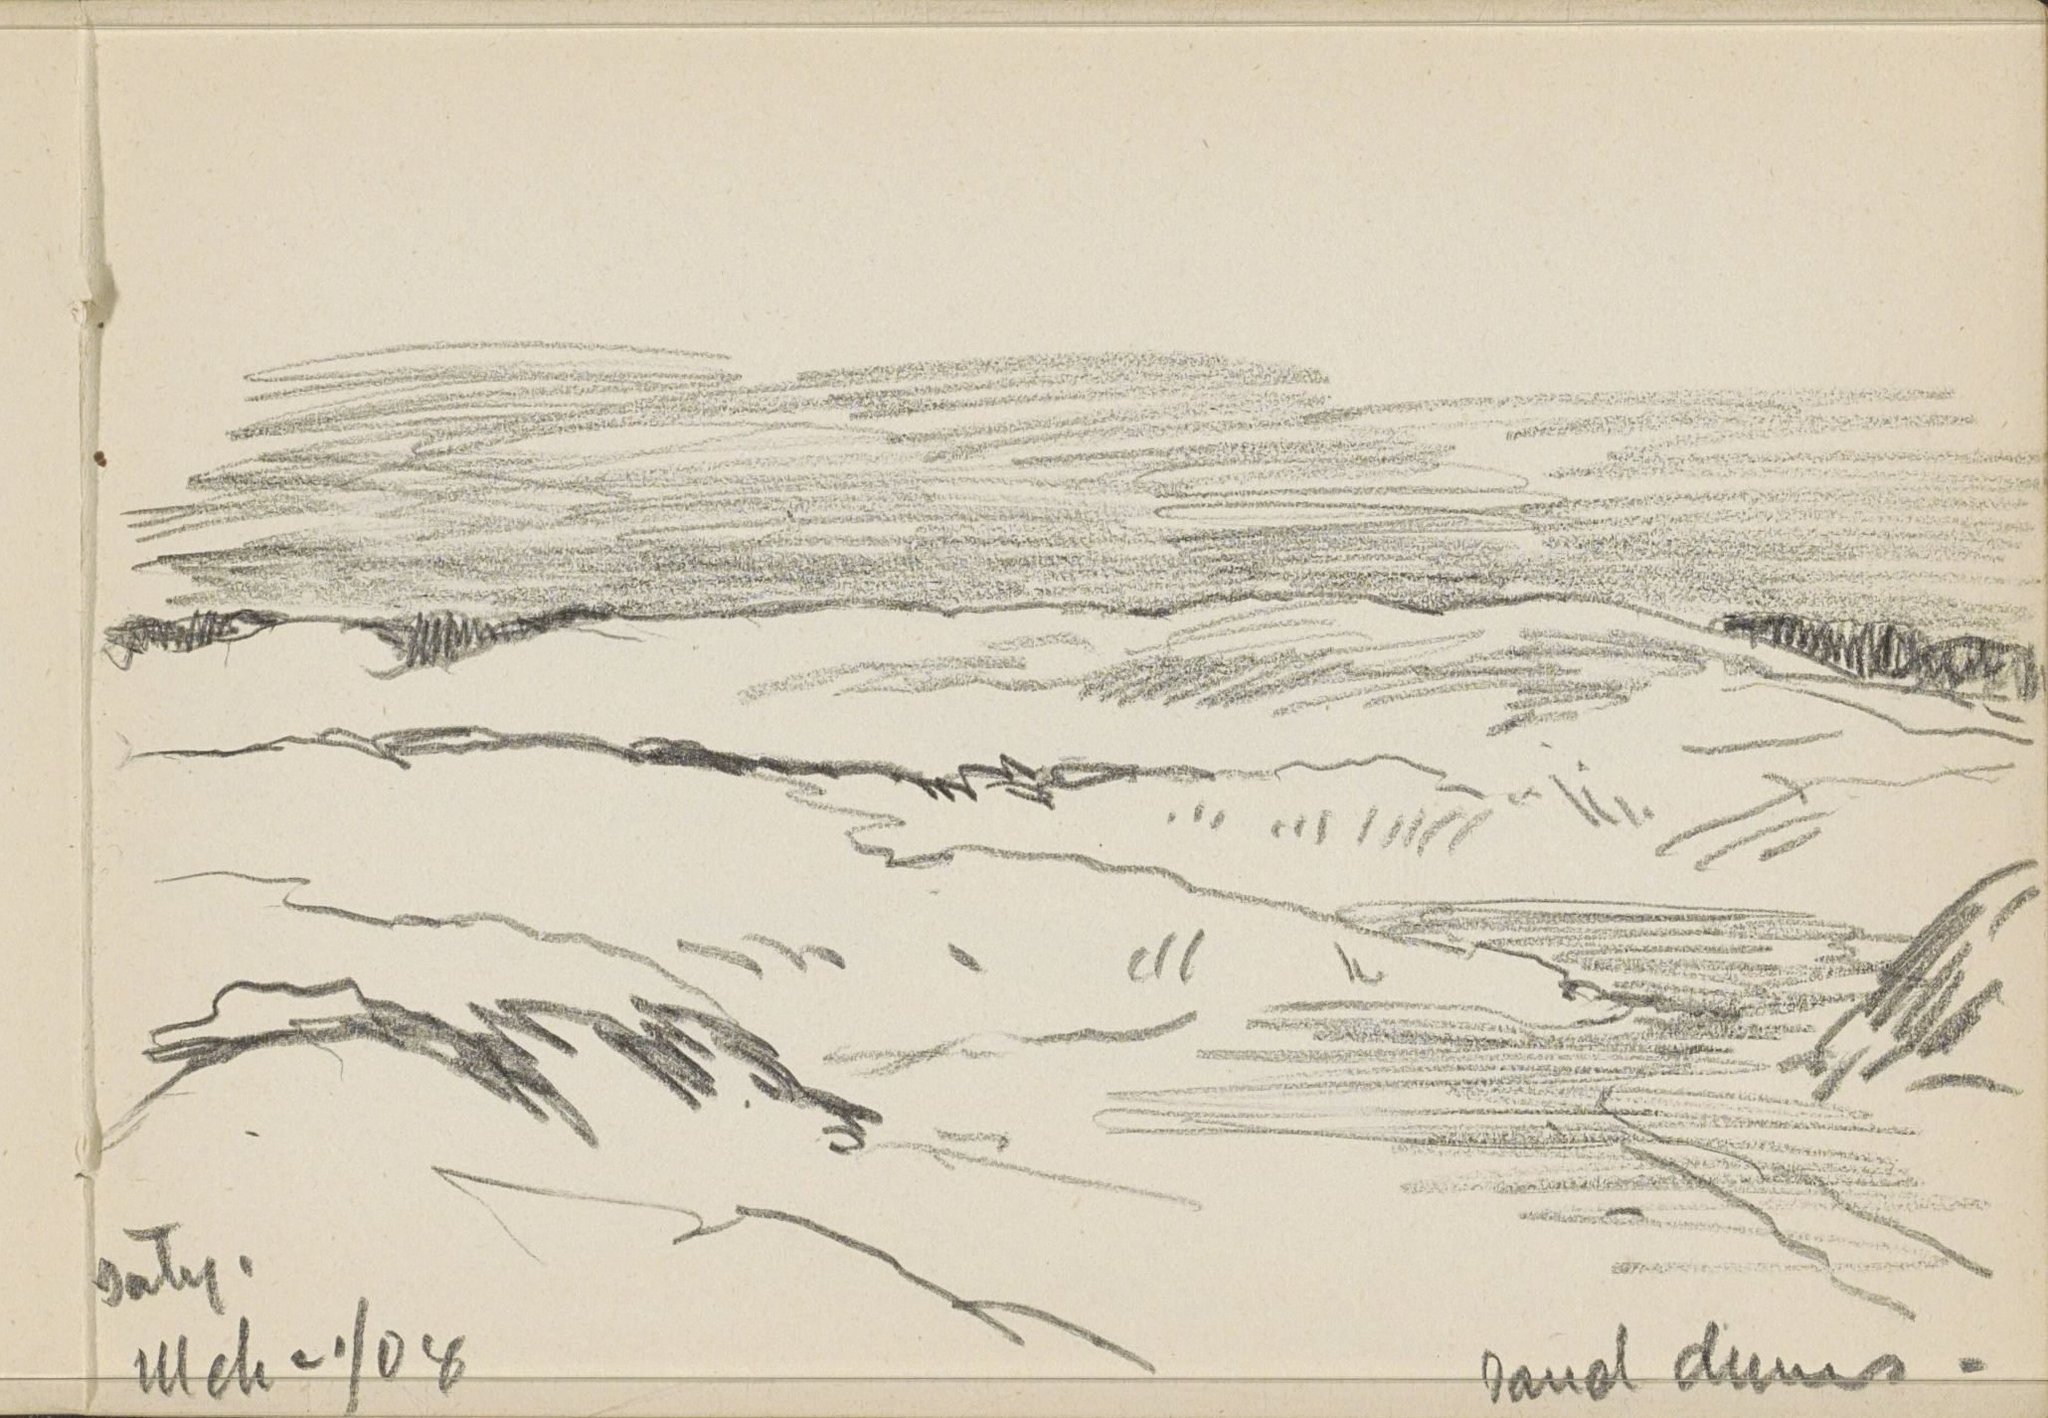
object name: sketchbook leaf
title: Duinlandschap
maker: alexander shilling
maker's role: draughtsman, print maker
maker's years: 1859-1937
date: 1903-1908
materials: chalk, paper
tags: dunes (sea not visible); in the dunes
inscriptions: date and inscription: ‘Saty/ Mch 21/08/ sand dunes-’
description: Blad 25 recto uit een schetsboek met 30 bladen.